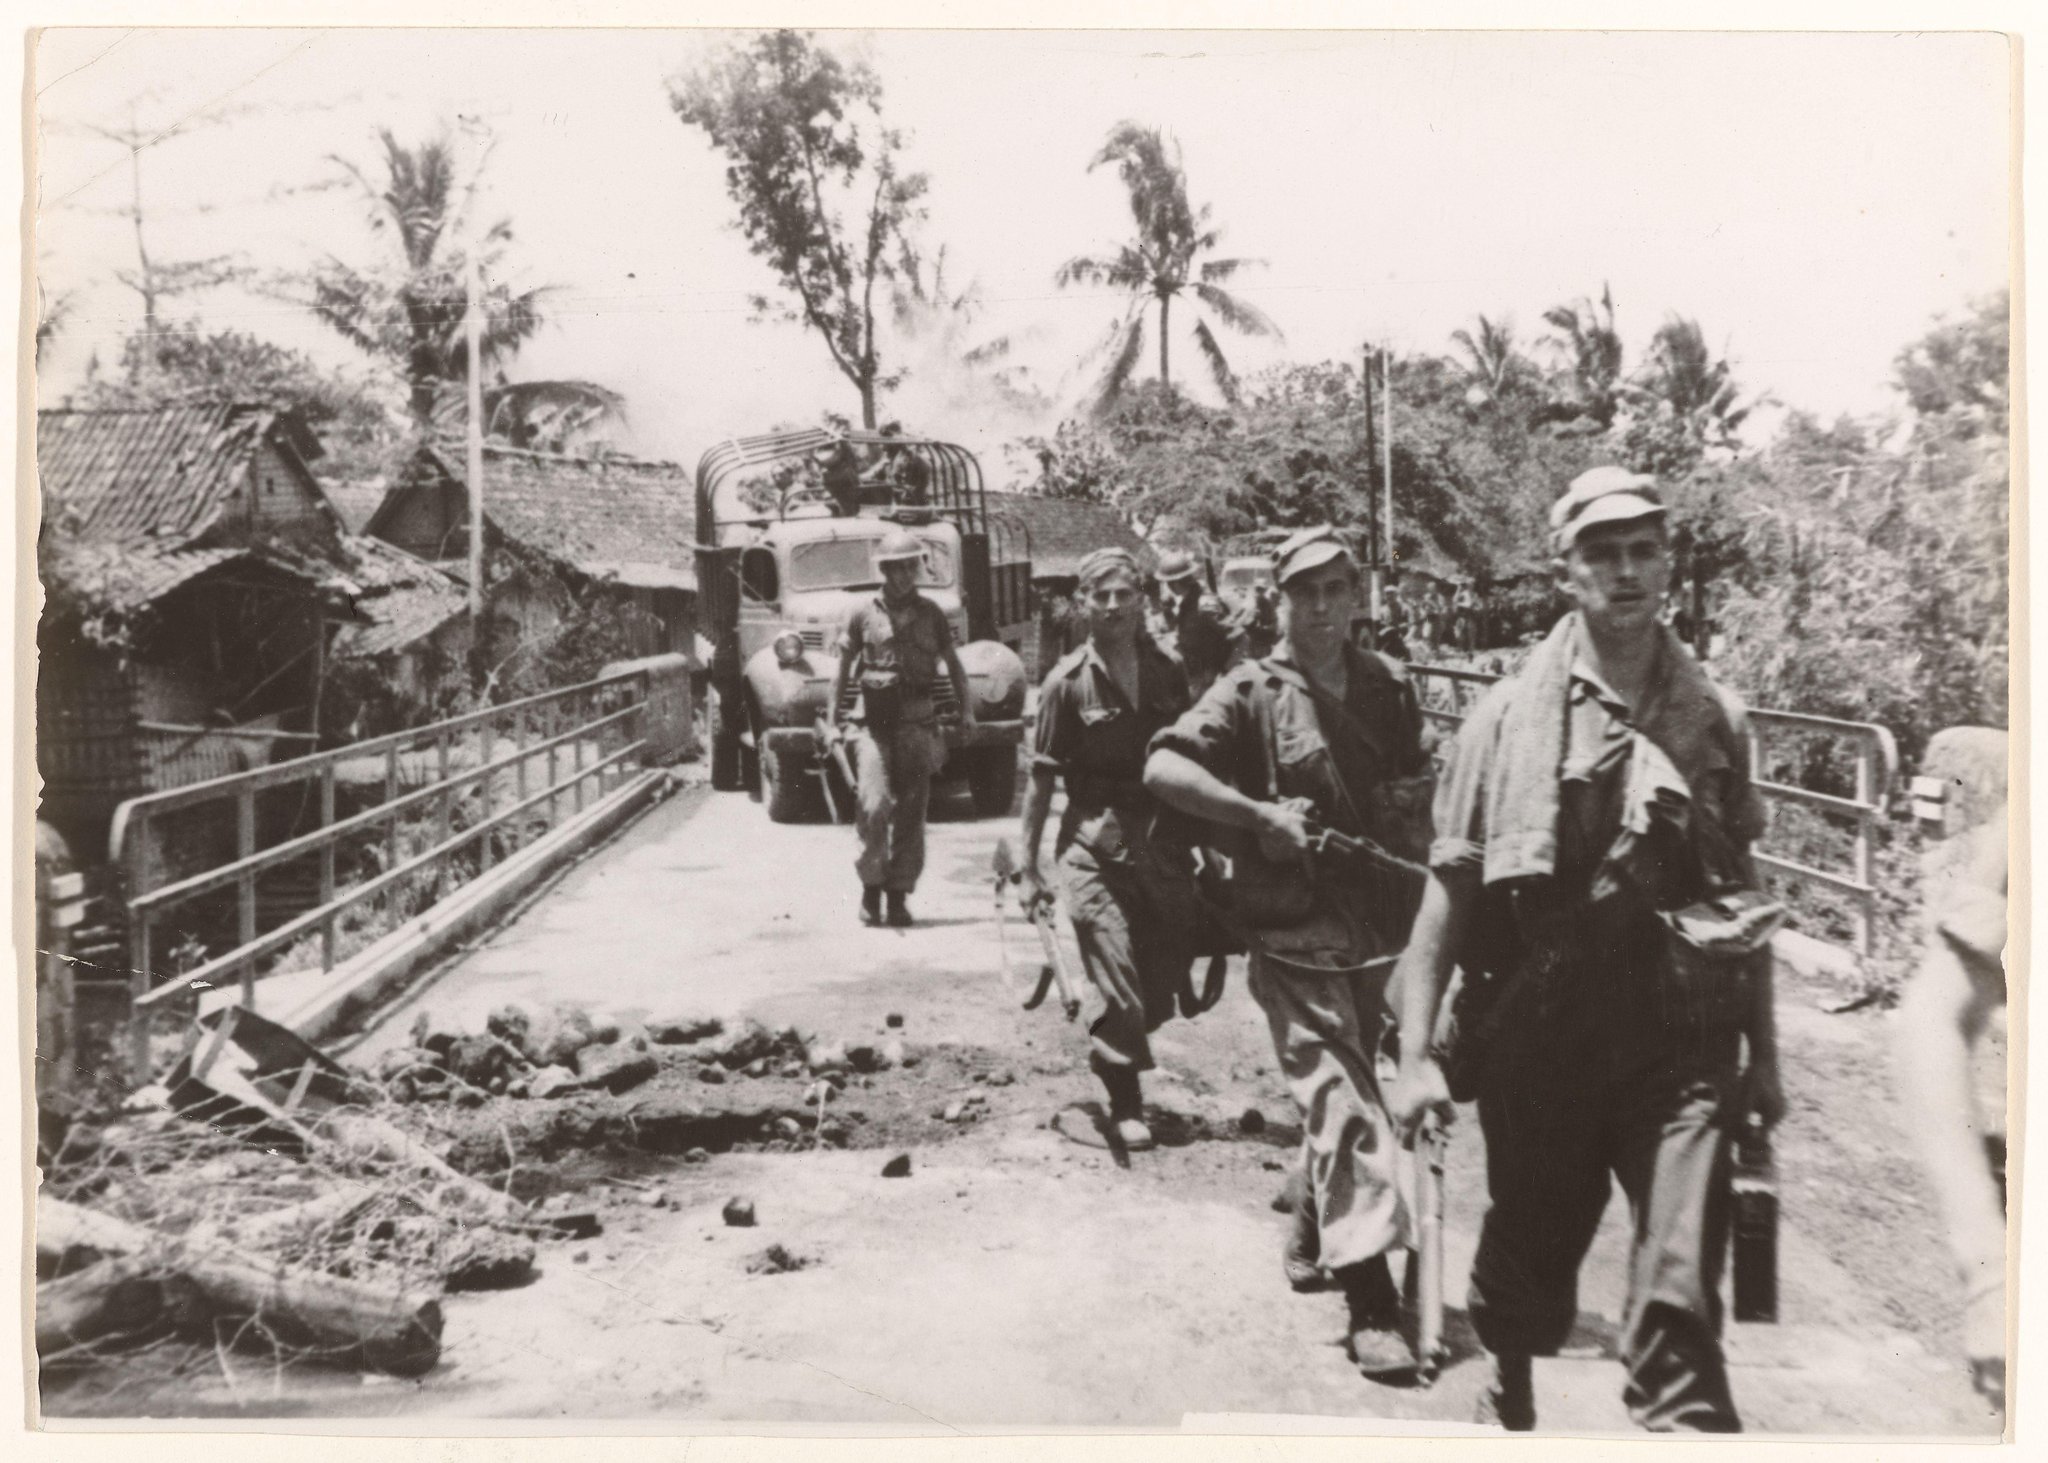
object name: photograph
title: Opmars naar Solo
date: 1949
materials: photographic support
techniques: photography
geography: java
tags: troop movements, transportation, java, dutch east indies, the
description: Nederlandse militairen lopen over een brug richting Solo nadat ze een bom onschadelijk hebben gemaakt, 6 januari 1949. Links de bom.